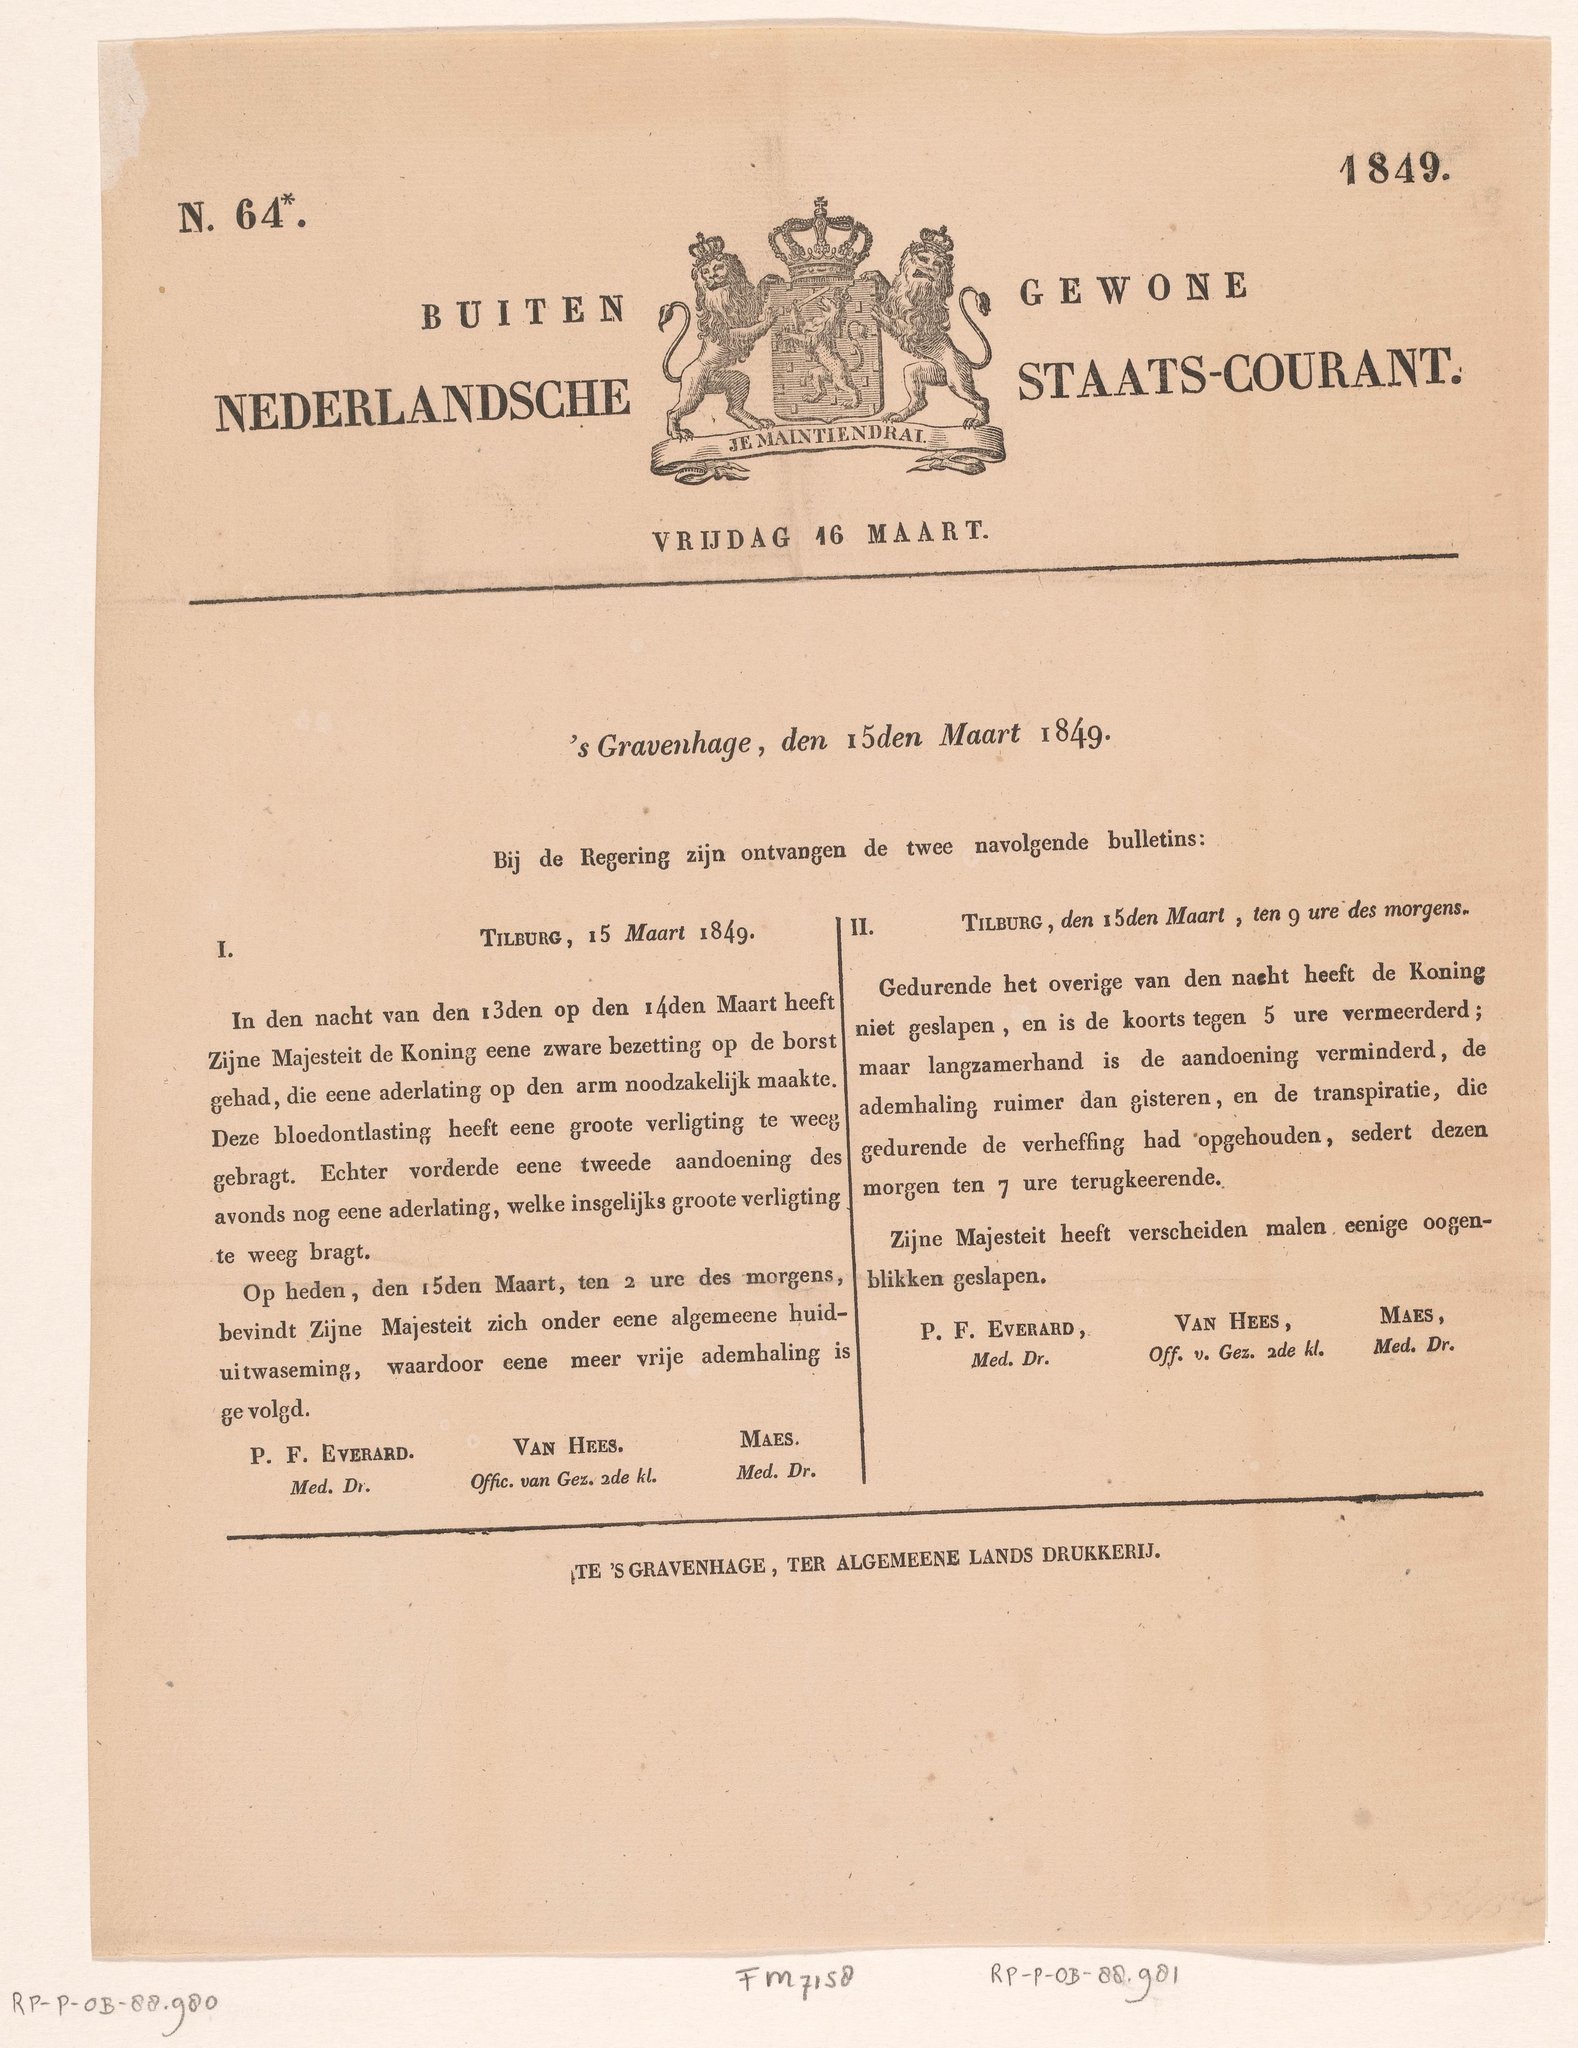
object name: newspaper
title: Buiten Gewone Nederlandsche Staats-Courant. Vrijdag 16 Maart. N. 64*. 1849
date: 1849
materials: paper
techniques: letterpress printing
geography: the hague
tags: the hague, william ii of the netherlands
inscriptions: collector's mark: Lugt 2228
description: Exemplaar van de Nederlandse Staatscourant van 16 maart 1849 met de publicatie van twee medische bulletins van 15 maart uit Tilburg over de gezondheid van koning Willem II. Blad bedrukt op één zijde. Bovenaan het rijkswapen.